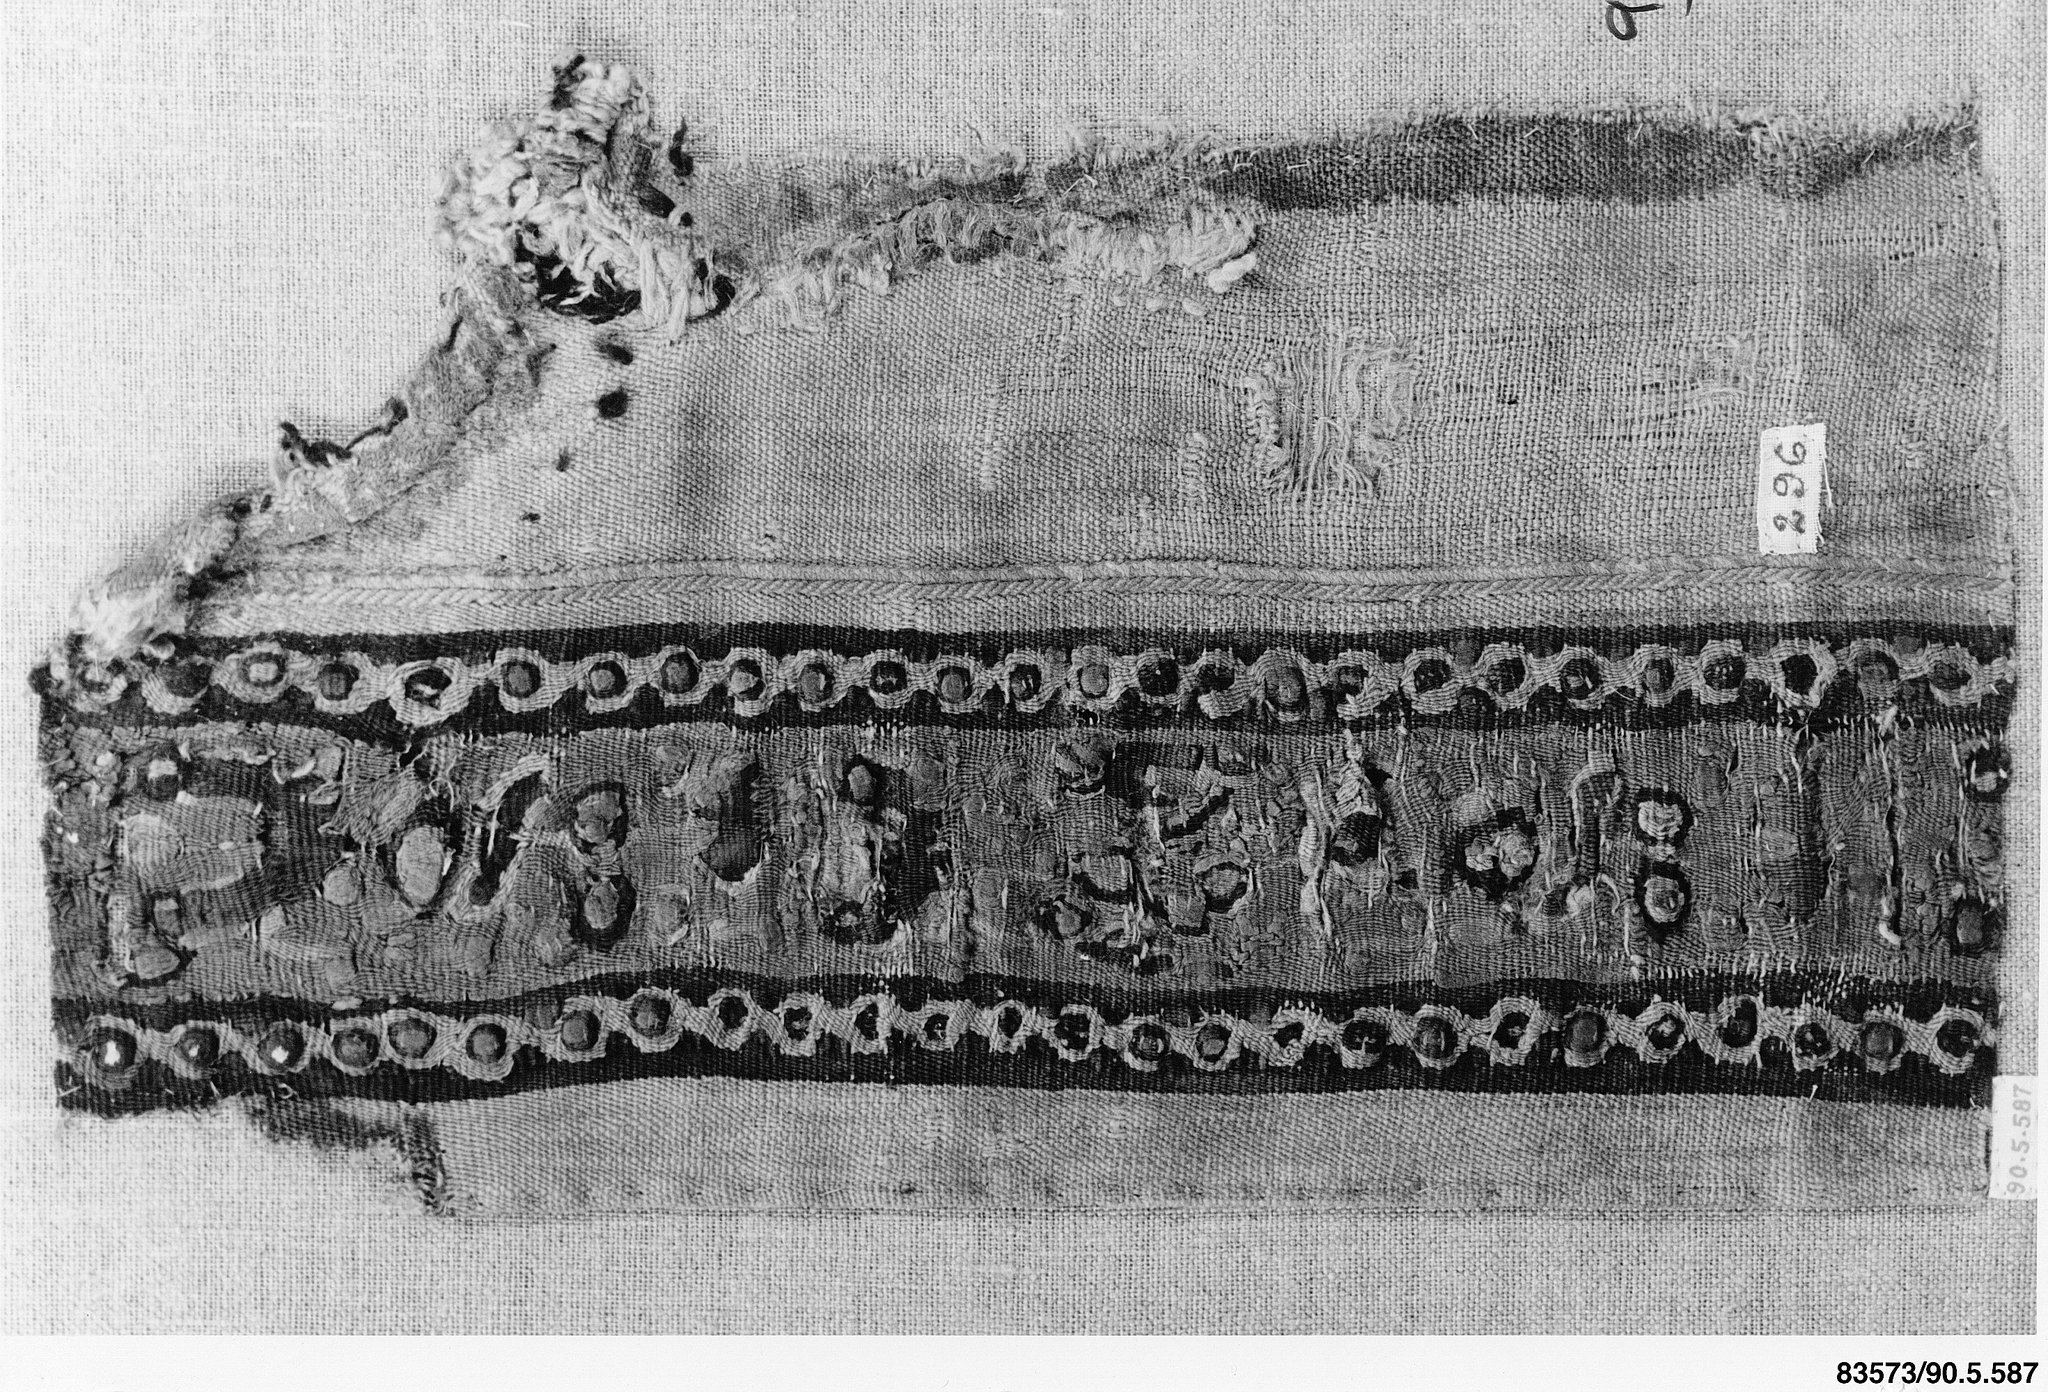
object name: textile fragment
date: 401-600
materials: linen, wool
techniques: weave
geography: egypt